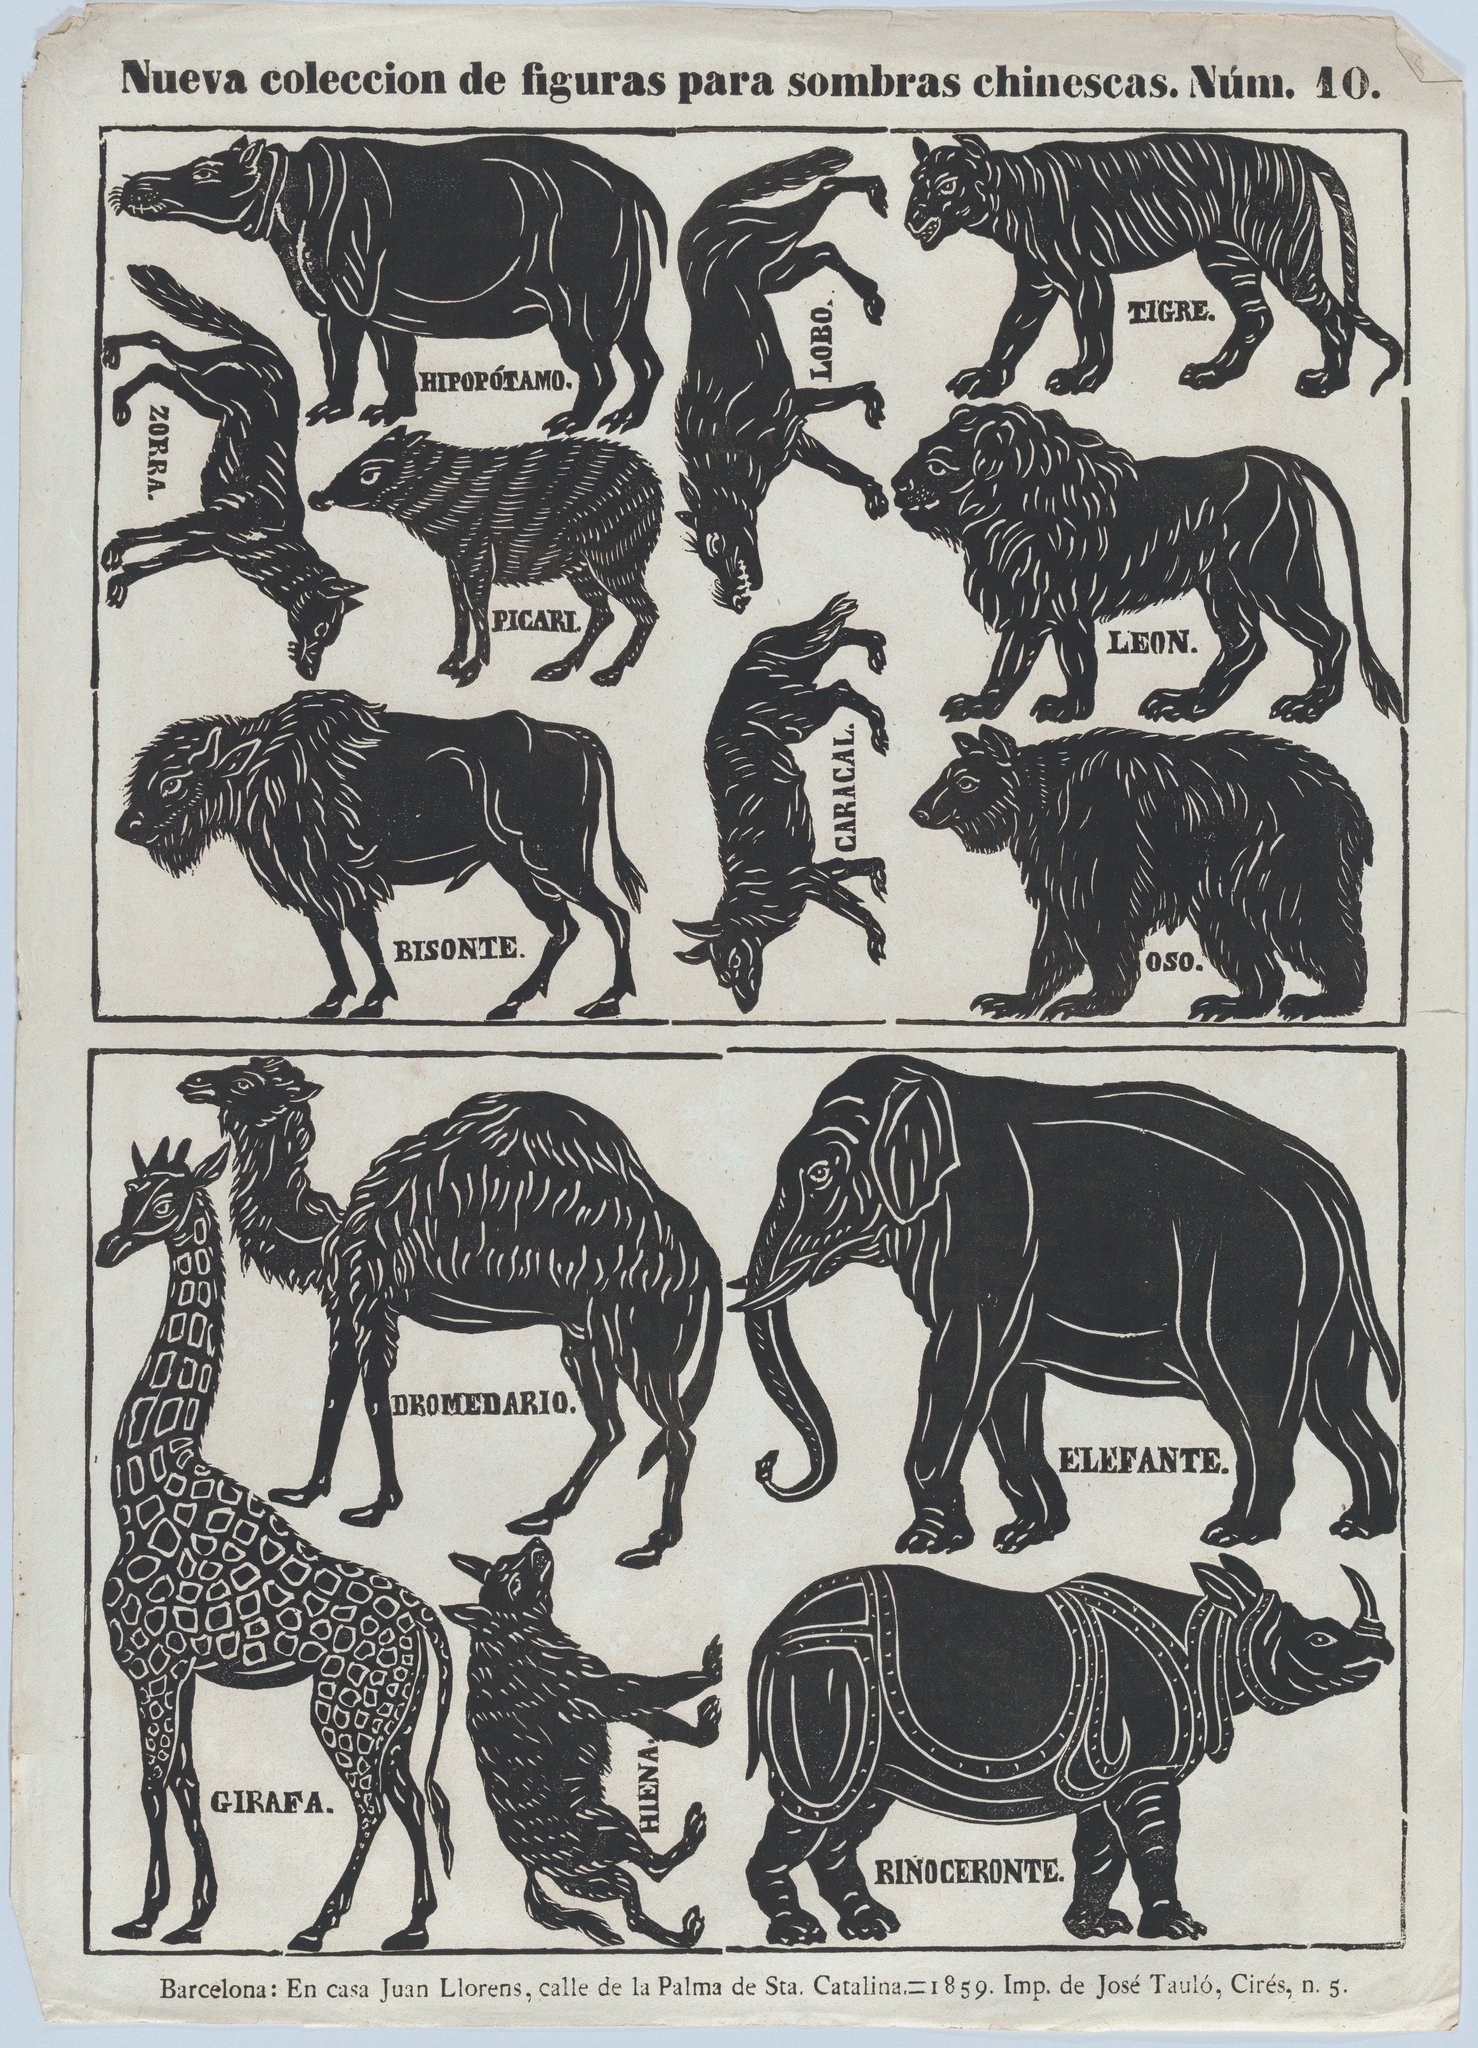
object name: print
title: Sheet 10 of figures for Chinese shadow puppets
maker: juan llorens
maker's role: publisher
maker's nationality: spanish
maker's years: 1800-1900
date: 1859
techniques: engraving, woodcut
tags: bears,boars,camels,elephants,lions,puppets